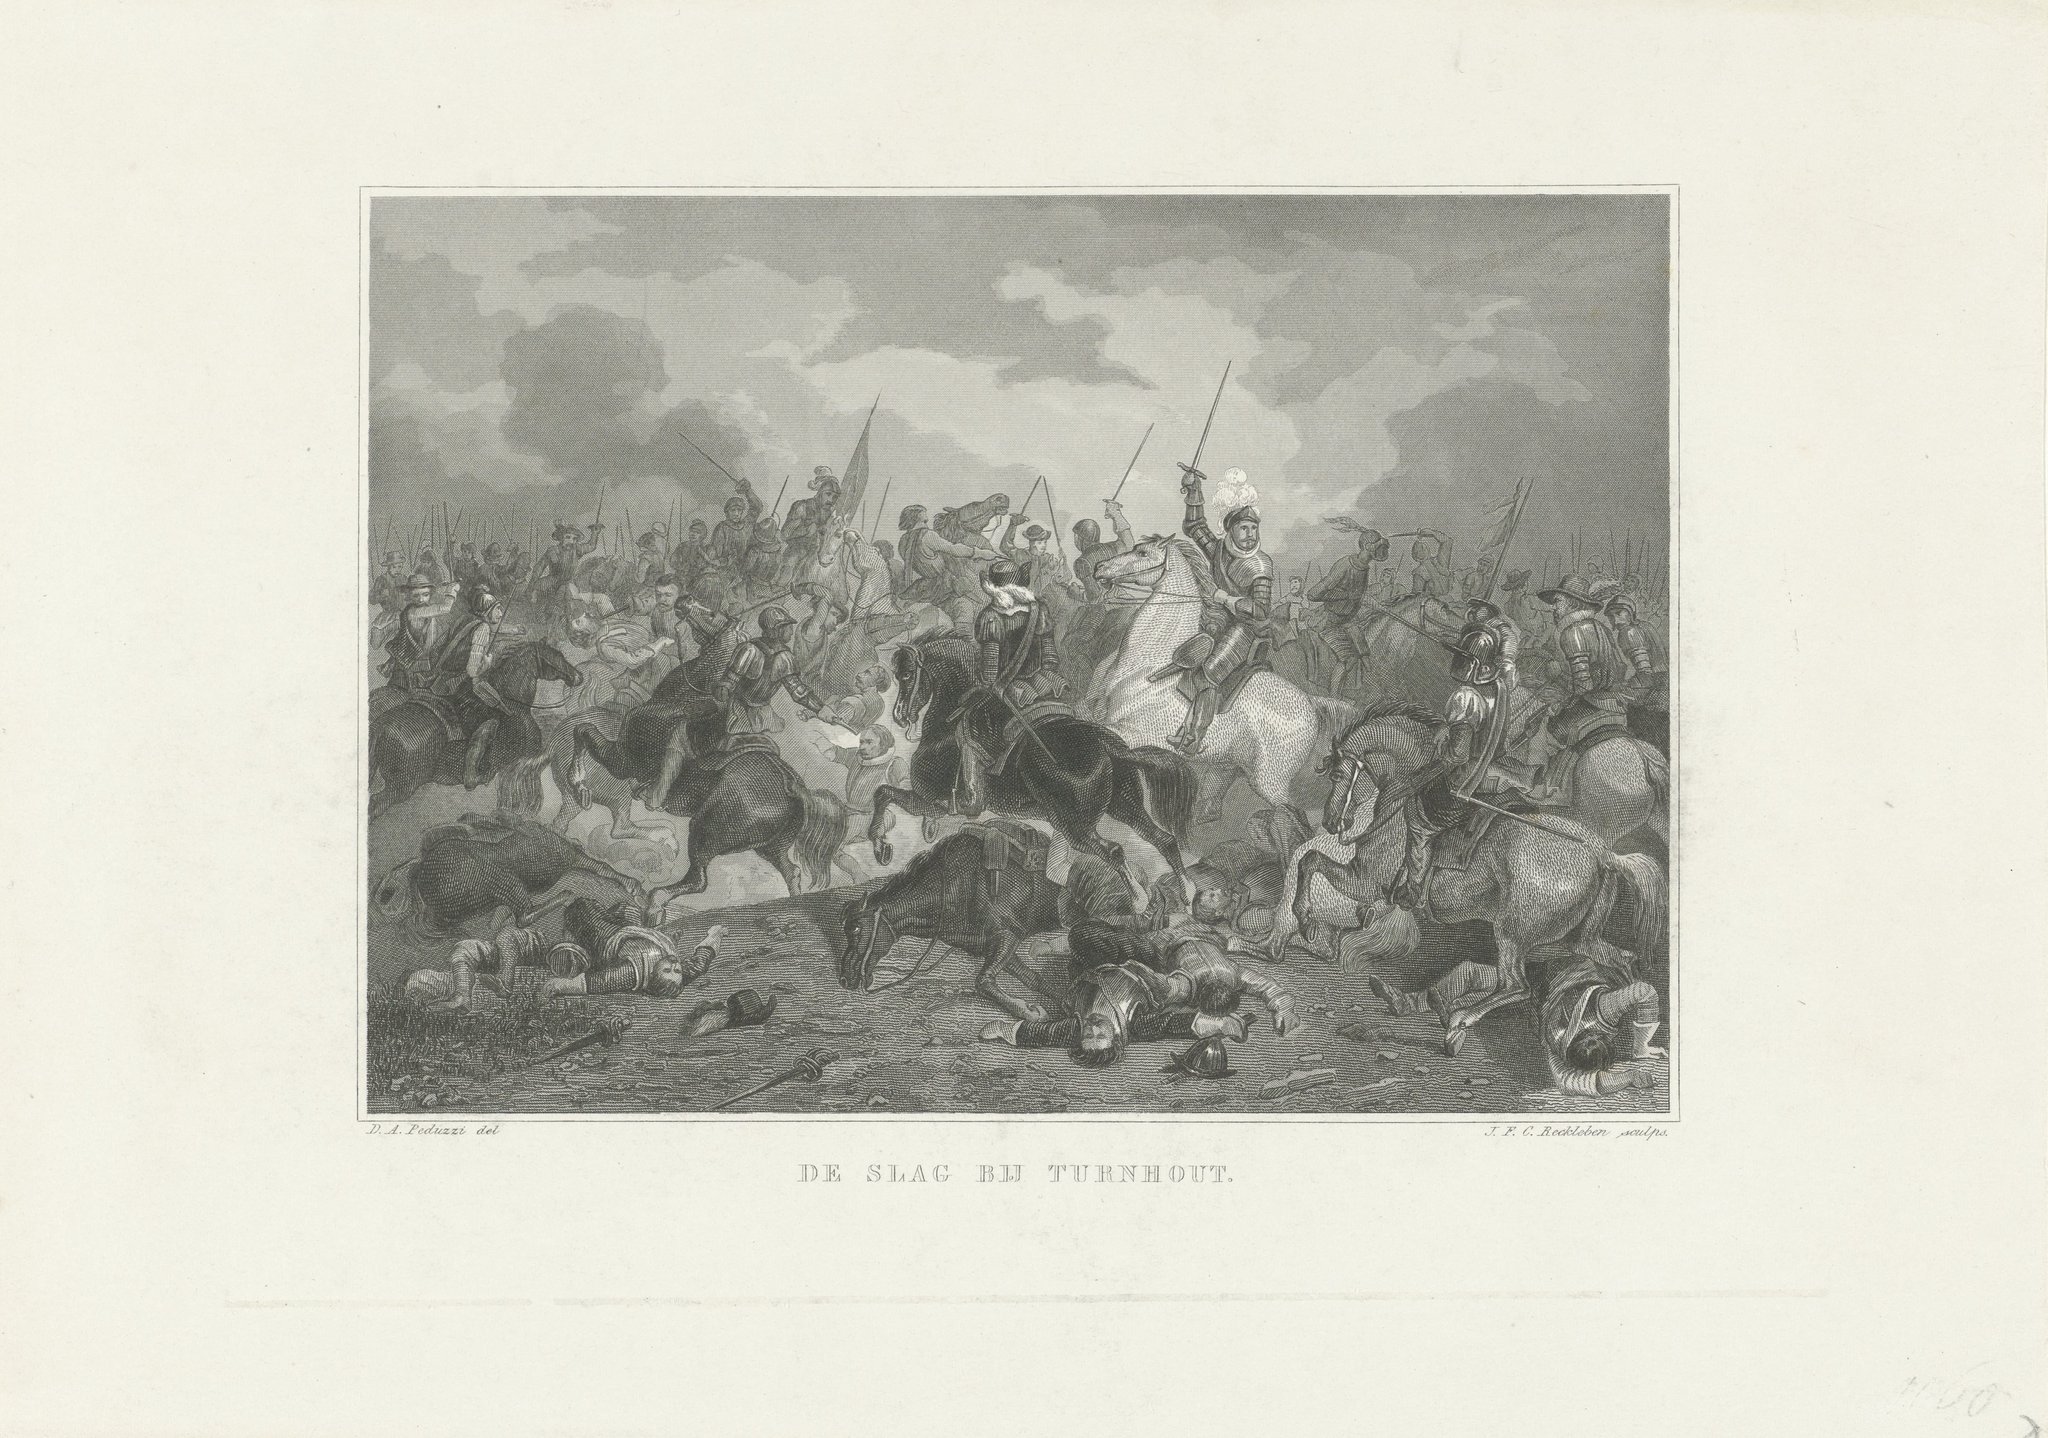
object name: print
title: Slag bij Turnhout, 1597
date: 1857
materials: paper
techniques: engraving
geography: amsterdam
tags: the hague, maurice (prince of orange), battle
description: Illustratie in: Arend, Johannes Pieter. Algemeene geschiedenis des vaderlands van de vroegste tijden tot op heden. 5 delen, Amsterdam: Schleijer, J.F. 1840-1884, dl. 3.2, p. 44/45.